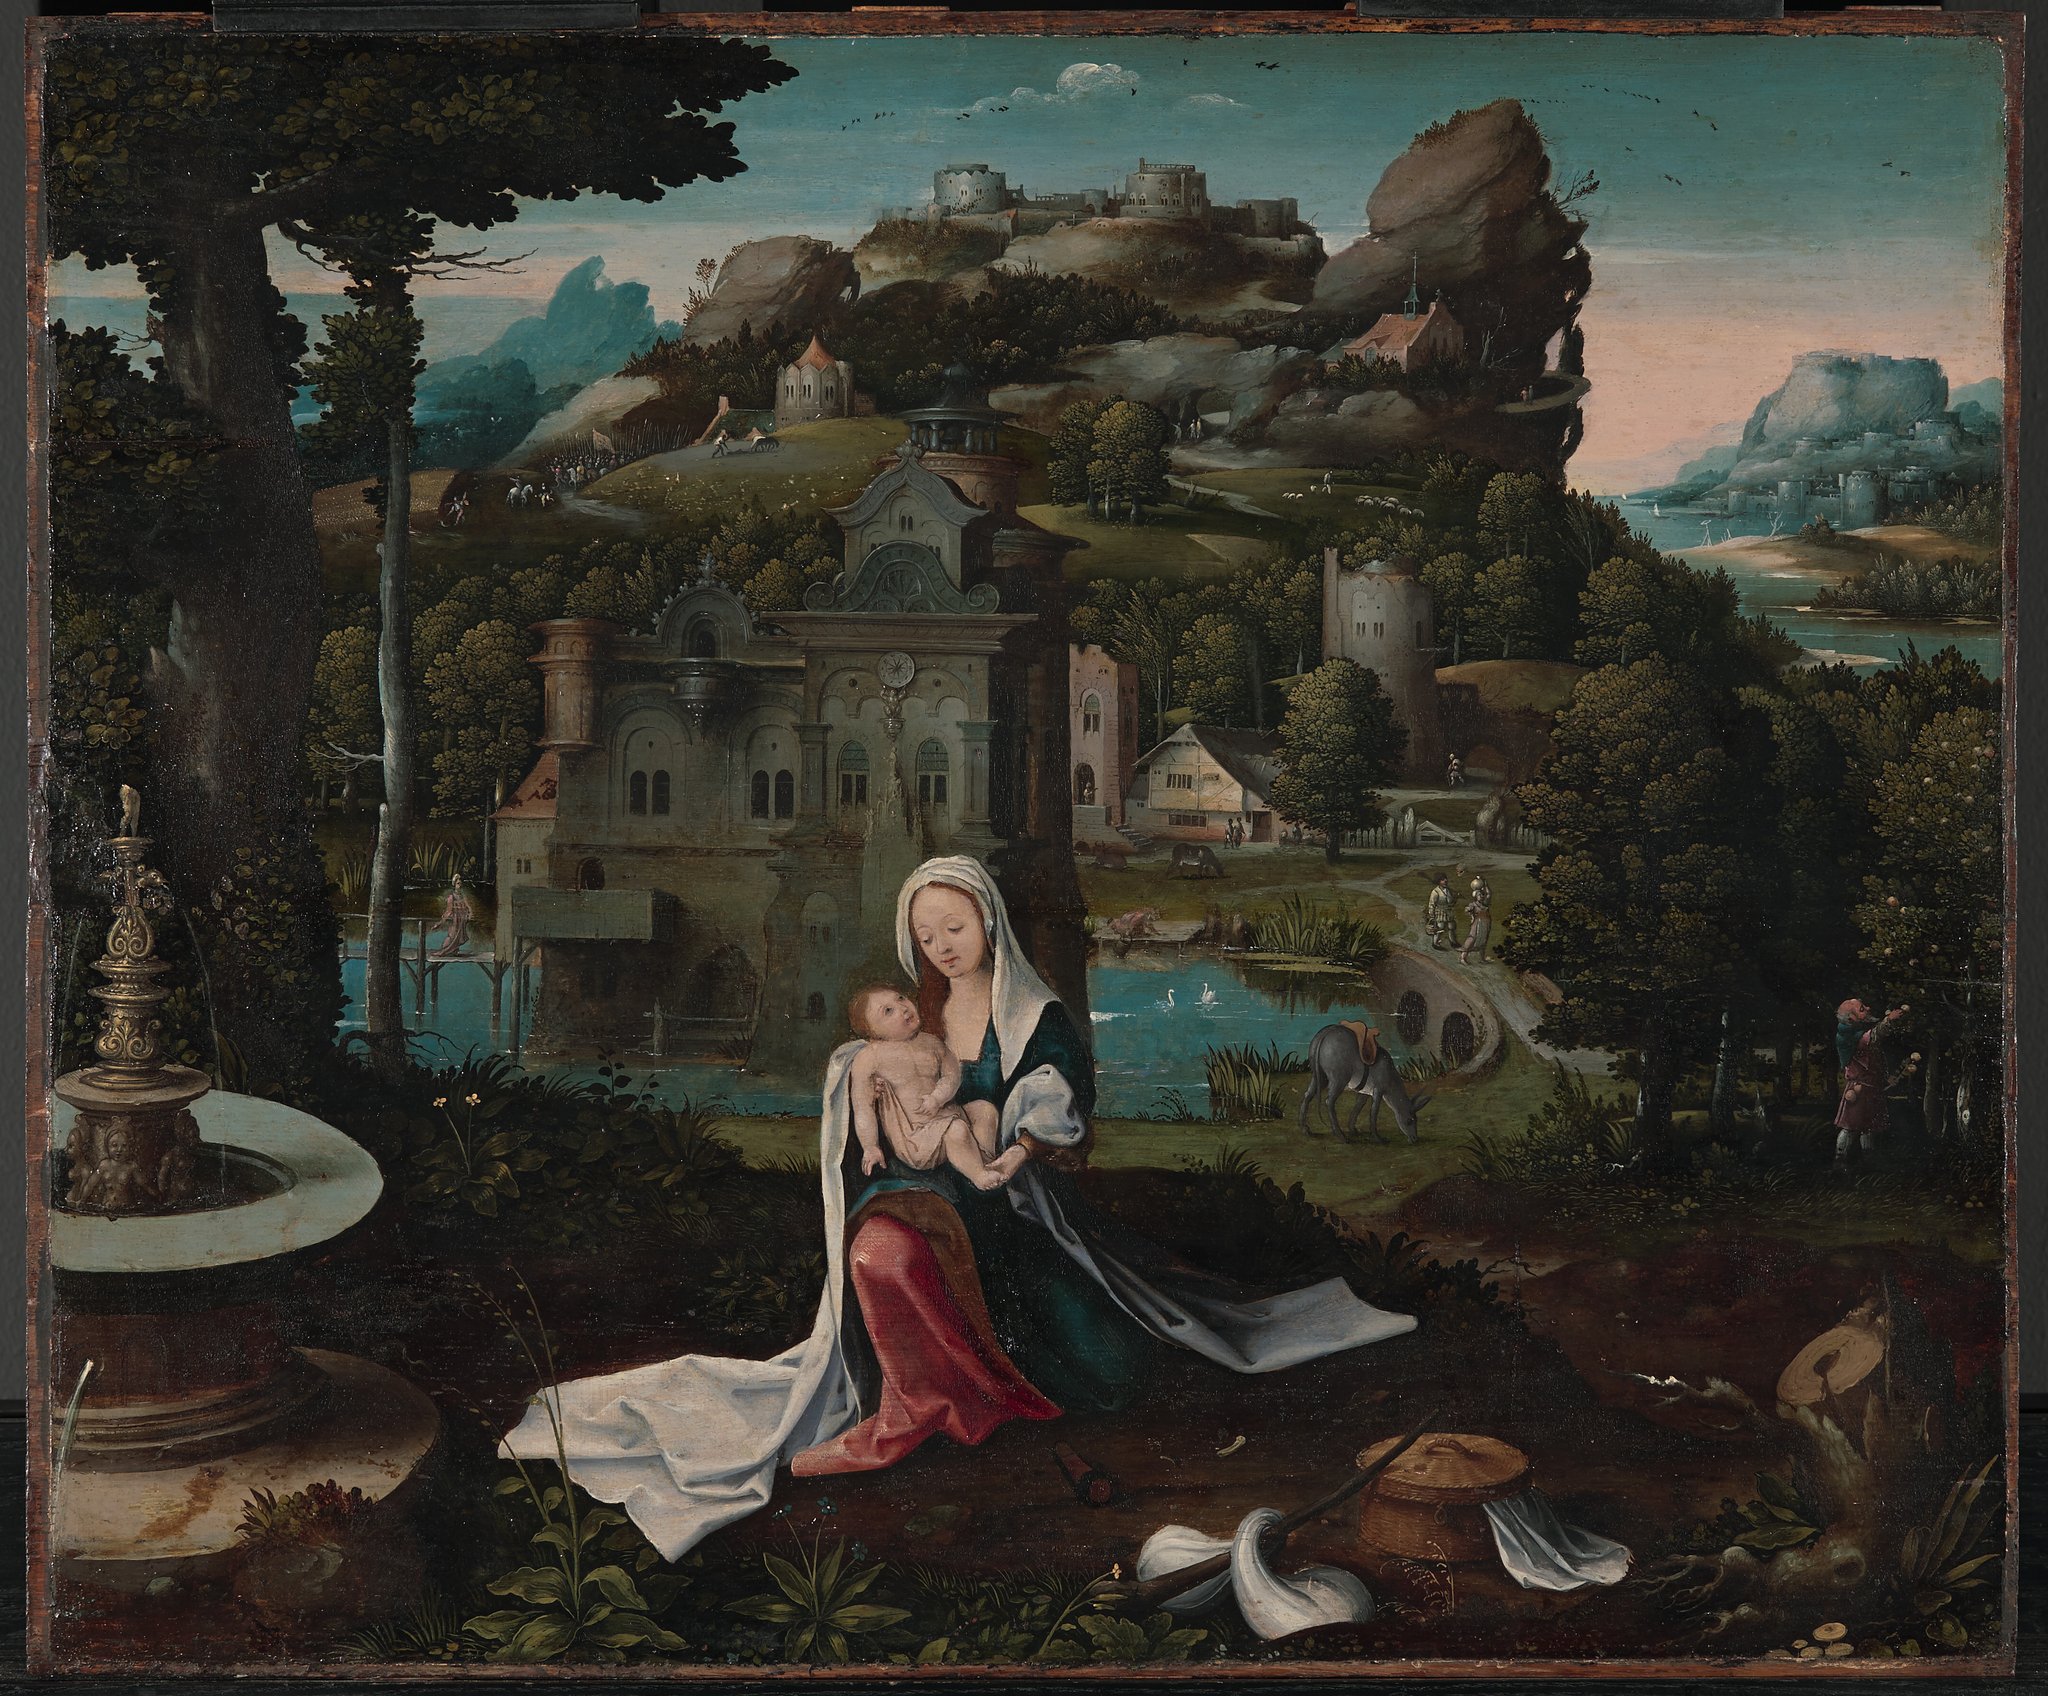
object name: painting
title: The Rest on the Flight into Egypt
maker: netherlandish (antwerp) painters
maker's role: artist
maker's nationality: netherlandish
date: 1530-1569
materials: oil, wood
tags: landscapes,holy family